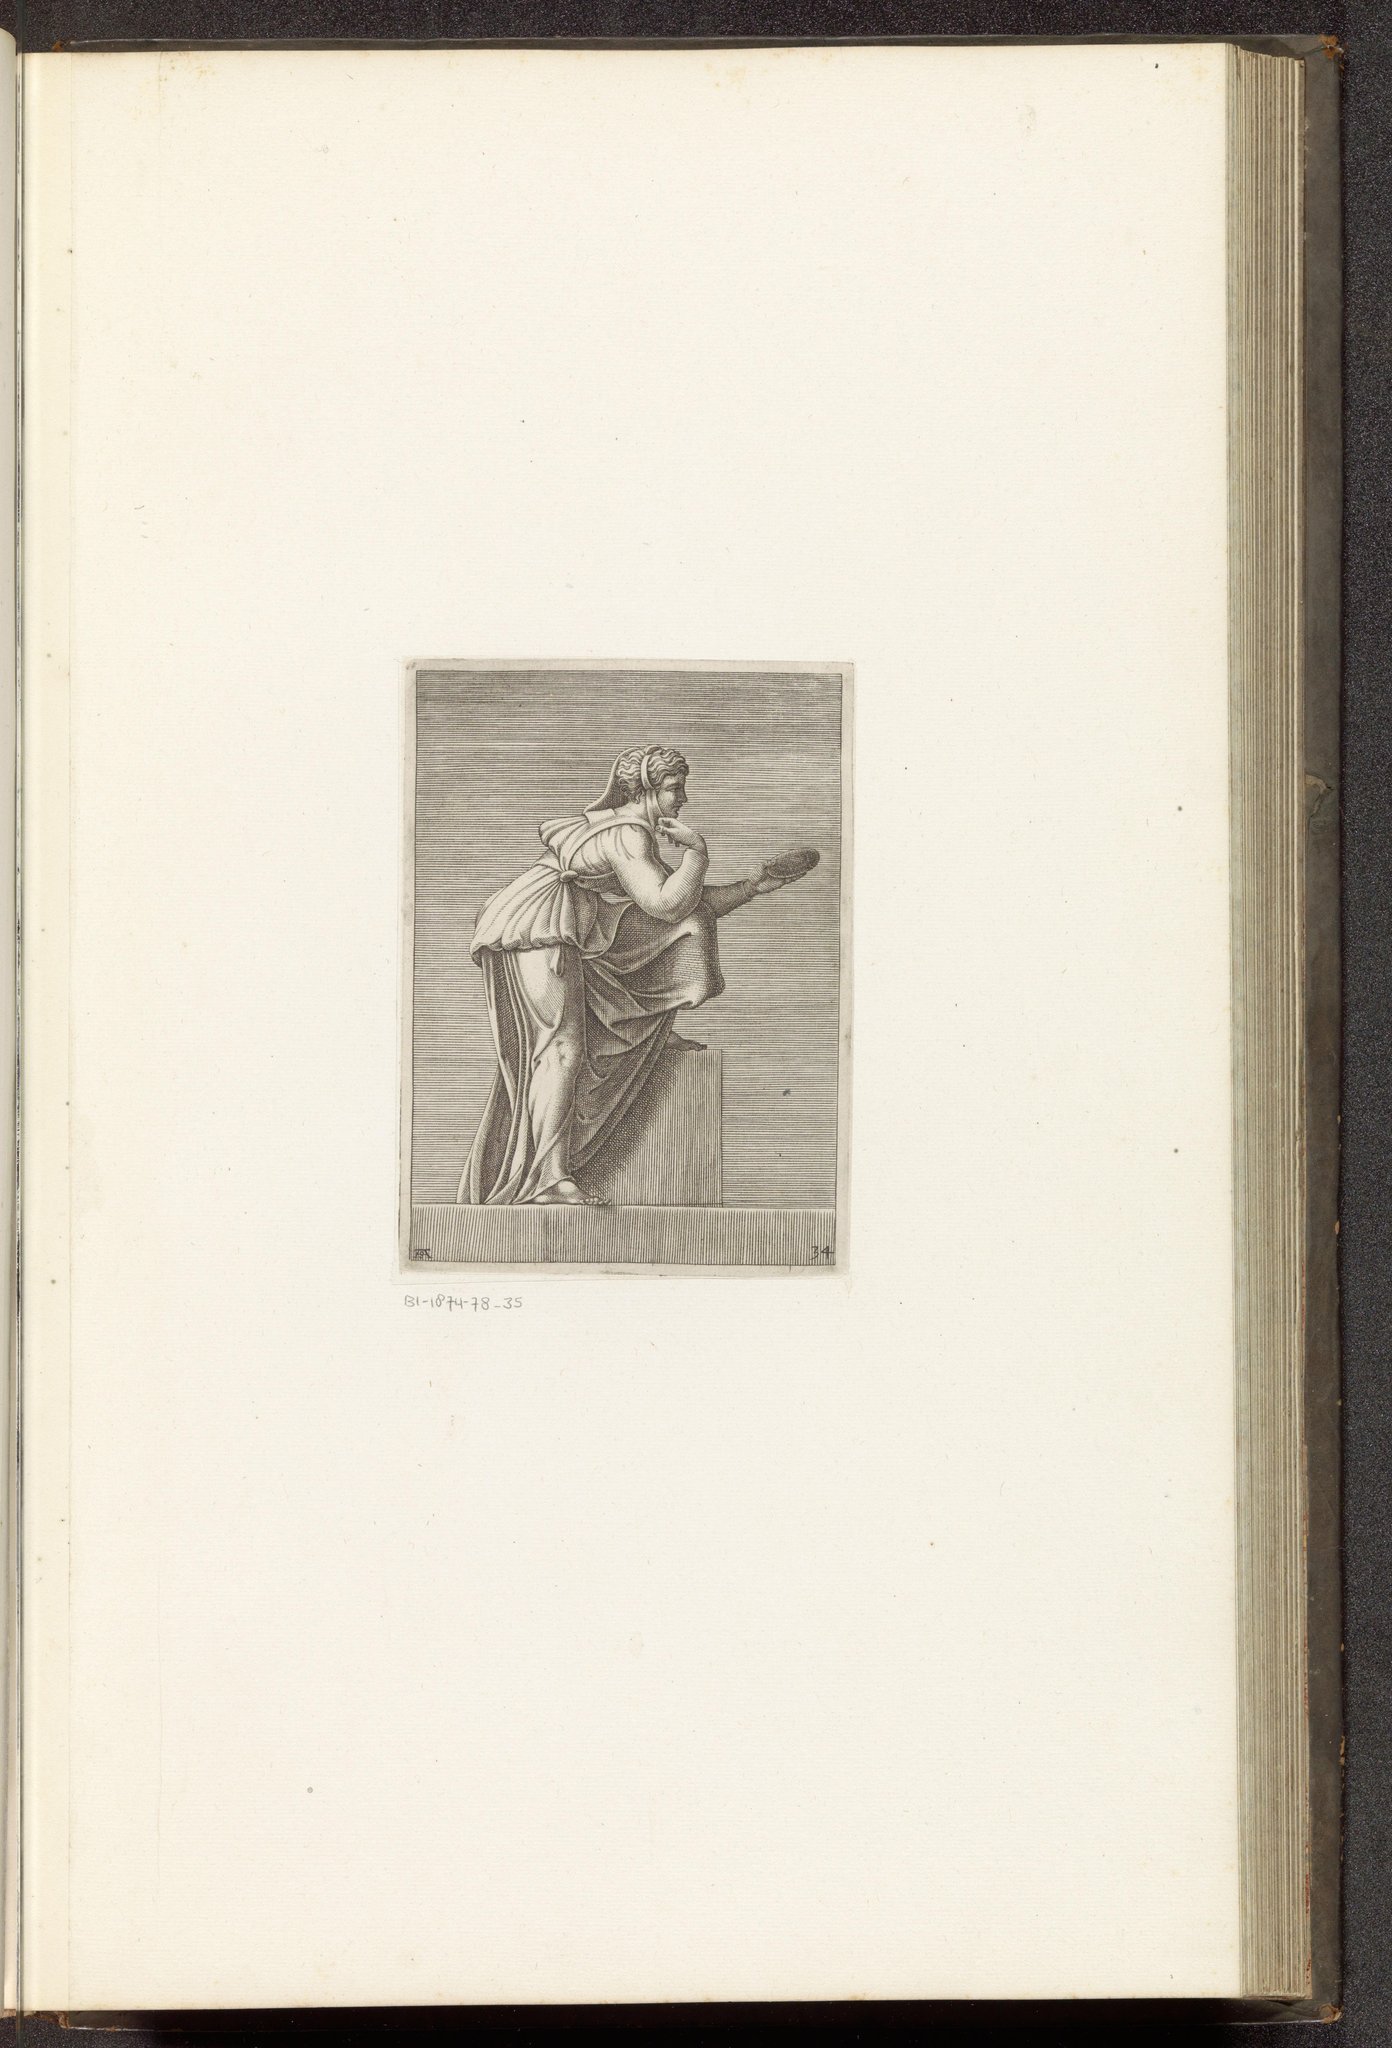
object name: album leaf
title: Vrouw met spiegel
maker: adamo scultori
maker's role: painter, print maker, sculptor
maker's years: 1530-1585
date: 1585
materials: paper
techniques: engraving, intaglio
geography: italy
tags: mirror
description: Staande vrouw met een spiegel in de hand. Figuur afkomstig van Michelangelo's plafondschildering. Genummerd rechtsonder: 34. De prent maakt deel uit van een album.